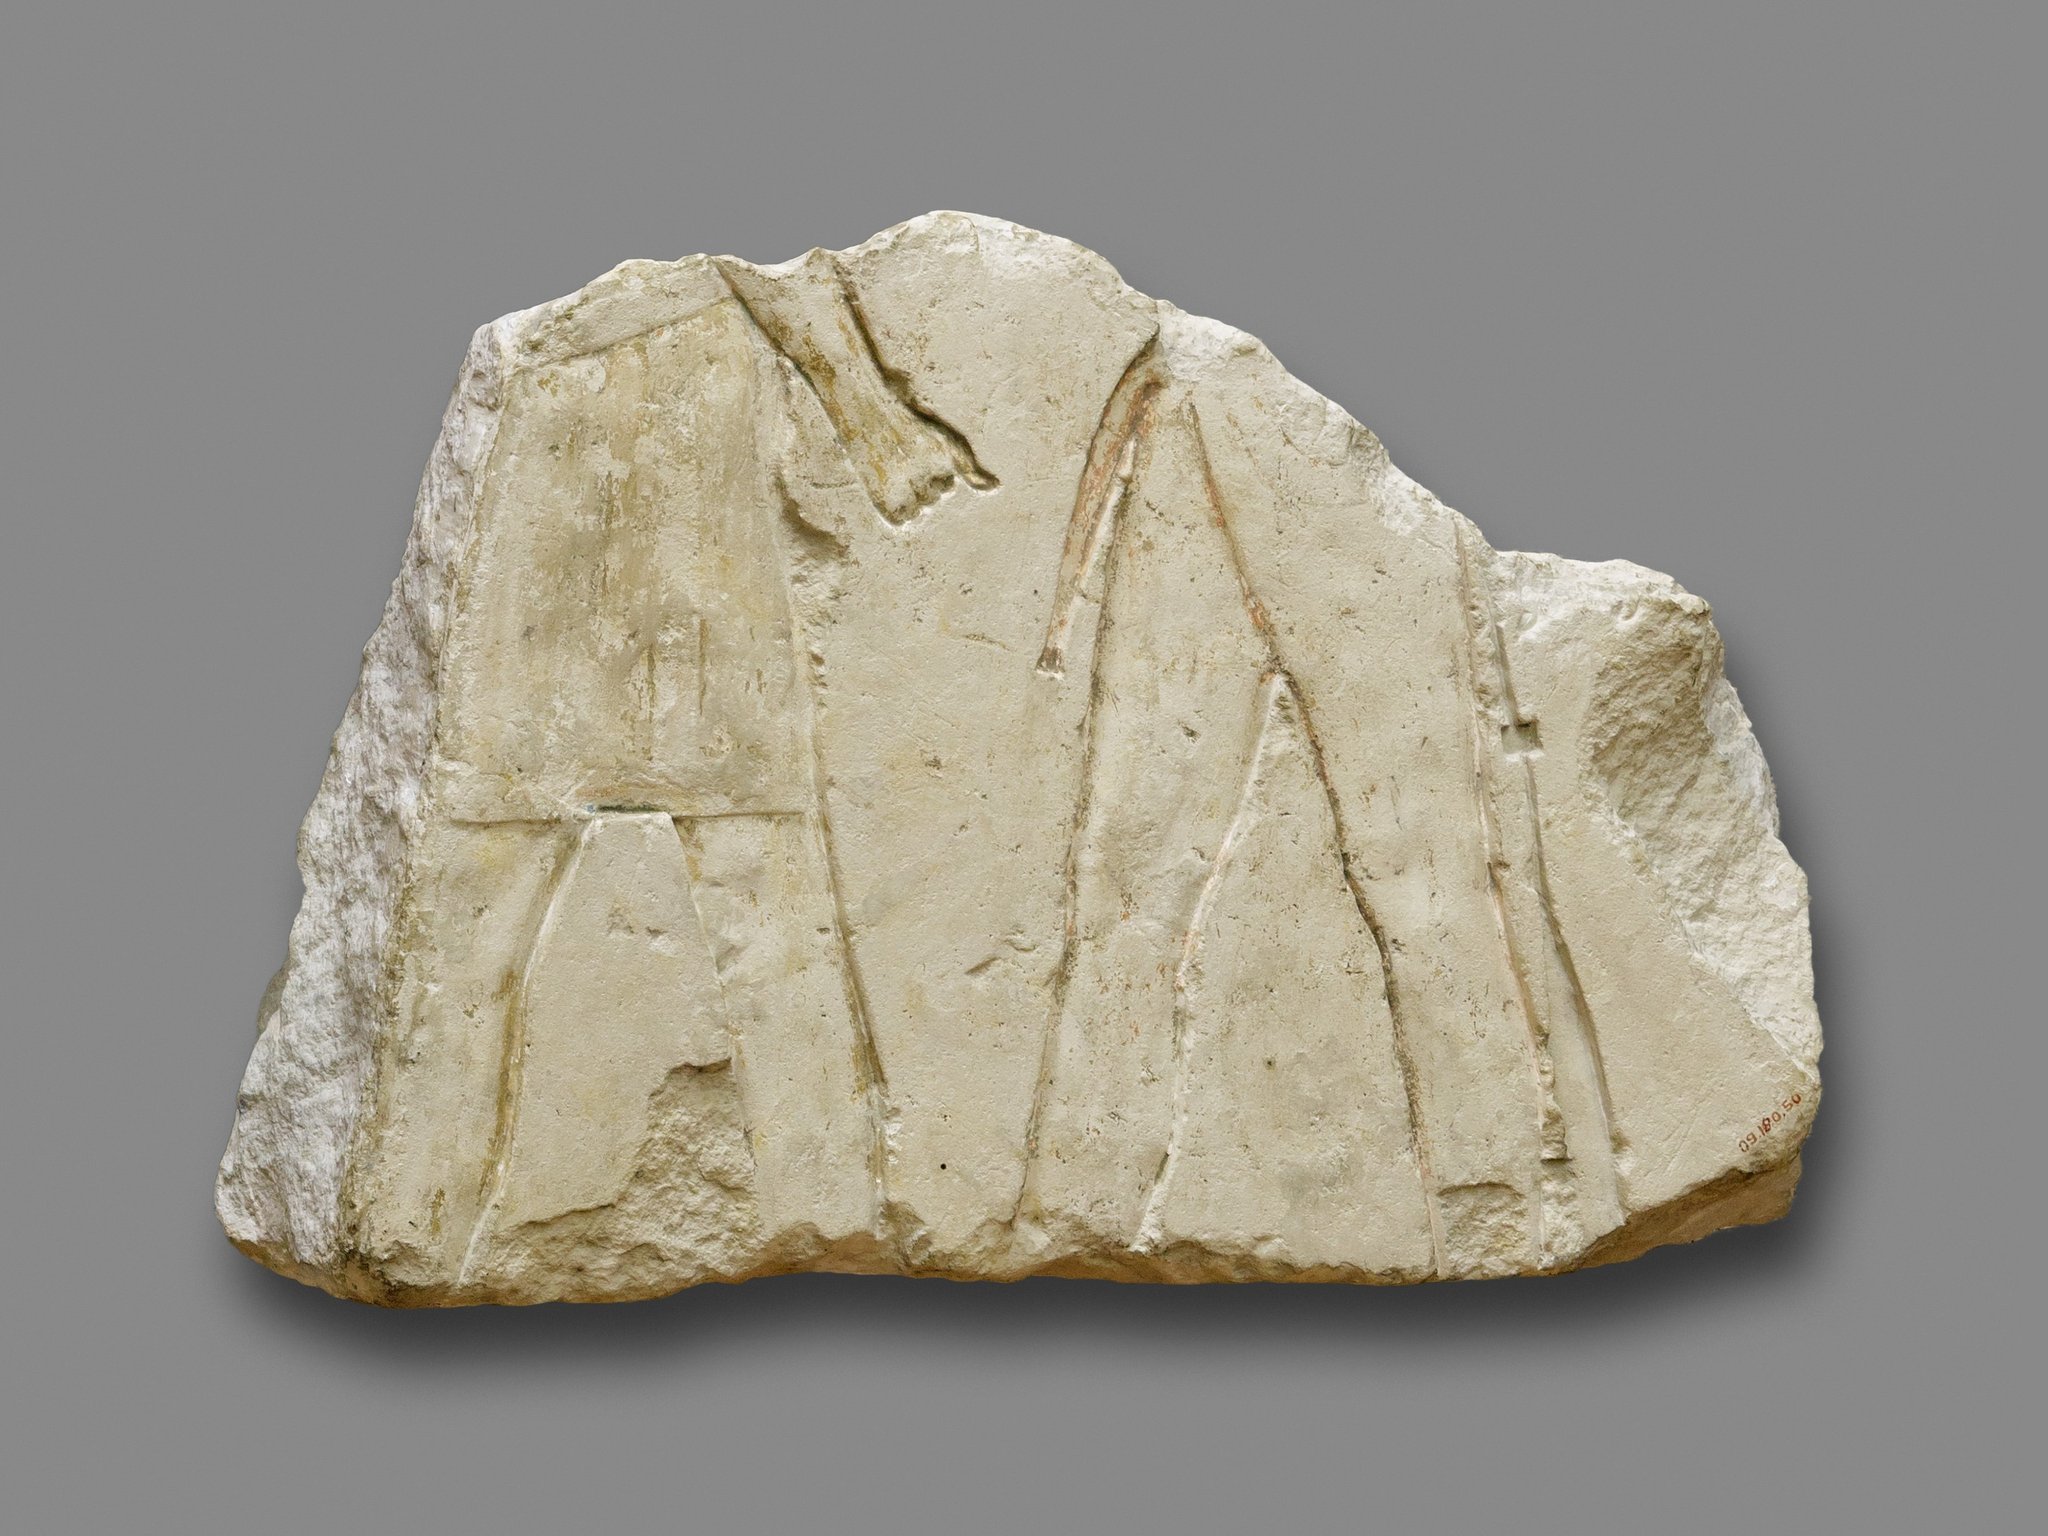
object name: relief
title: Block of Relief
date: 1961-1917 BCE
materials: limestone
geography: egypt